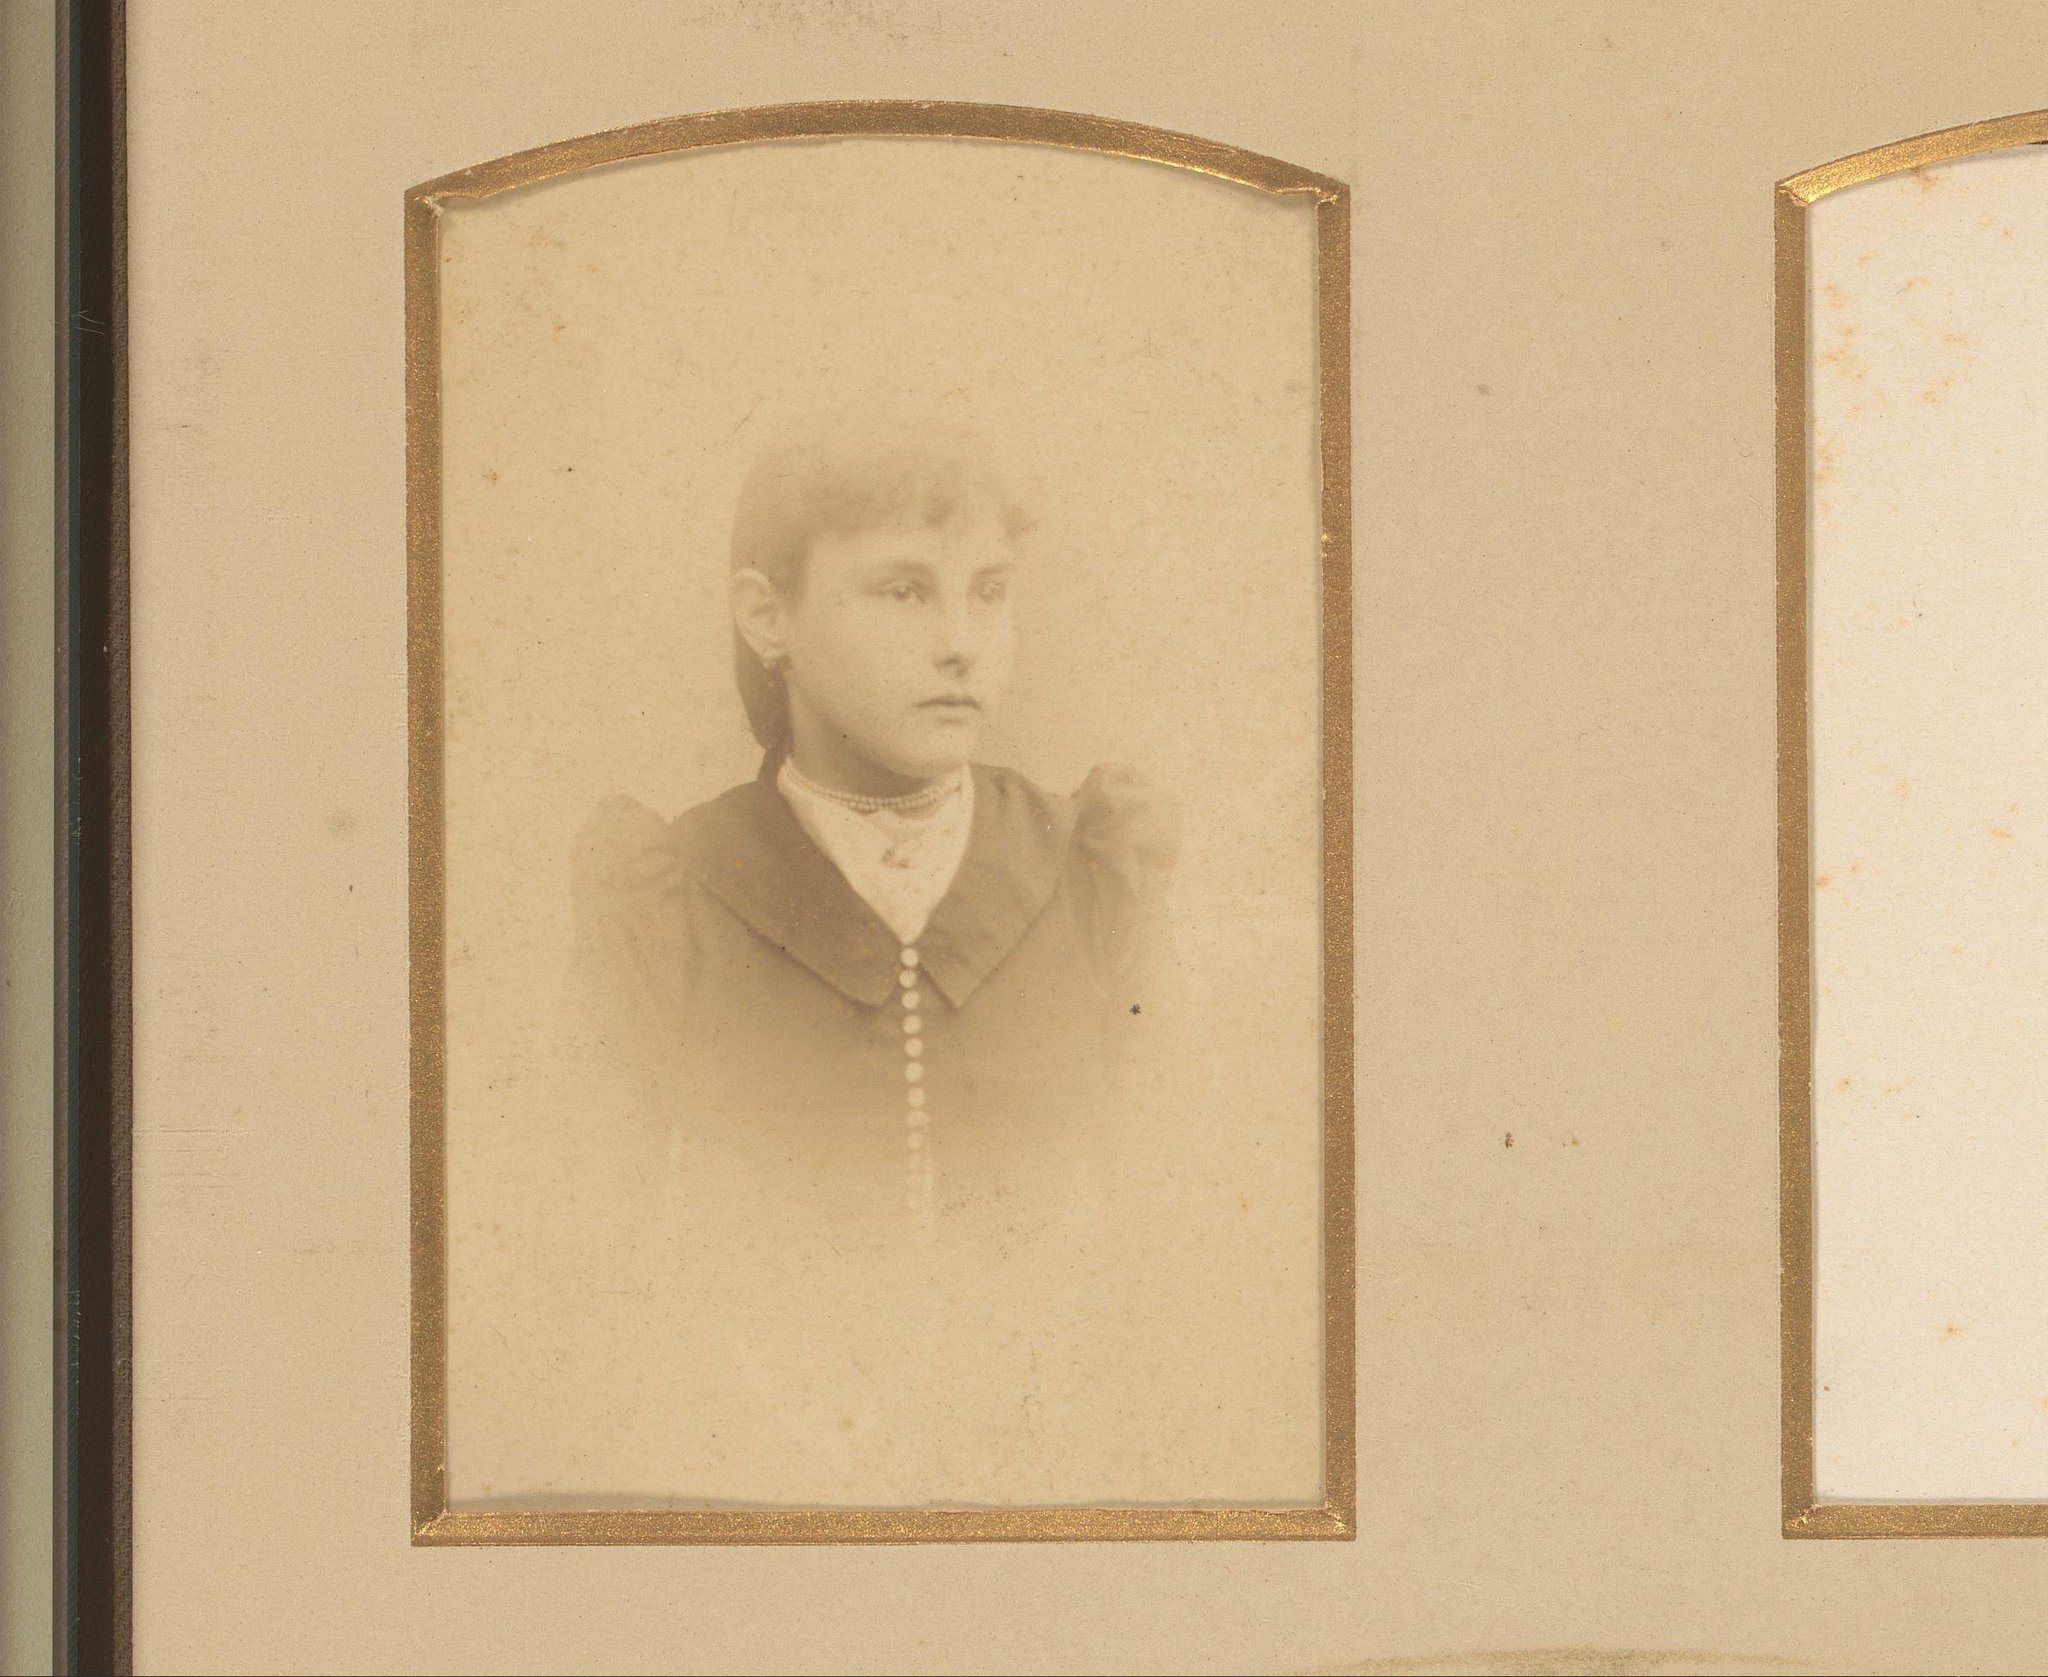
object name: album leaf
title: Portret van een meisje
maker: cornelis johannes lodewicus vermeulen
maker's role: fotograaf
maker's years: 1861-1936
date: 1888-1896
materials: cardboard, photographic support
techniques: albumen print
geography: amsterdam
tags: historical persons - bb - woman, girl (child between toddler and youth)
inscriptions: inscription: ‘Atelier/ Vermeulen/ Speciaal ingericht voor/ groepen en levensgroote portretten/ in onveranderlijke kooldruk/ Heerenstraat 6,/ Amsterdam.’